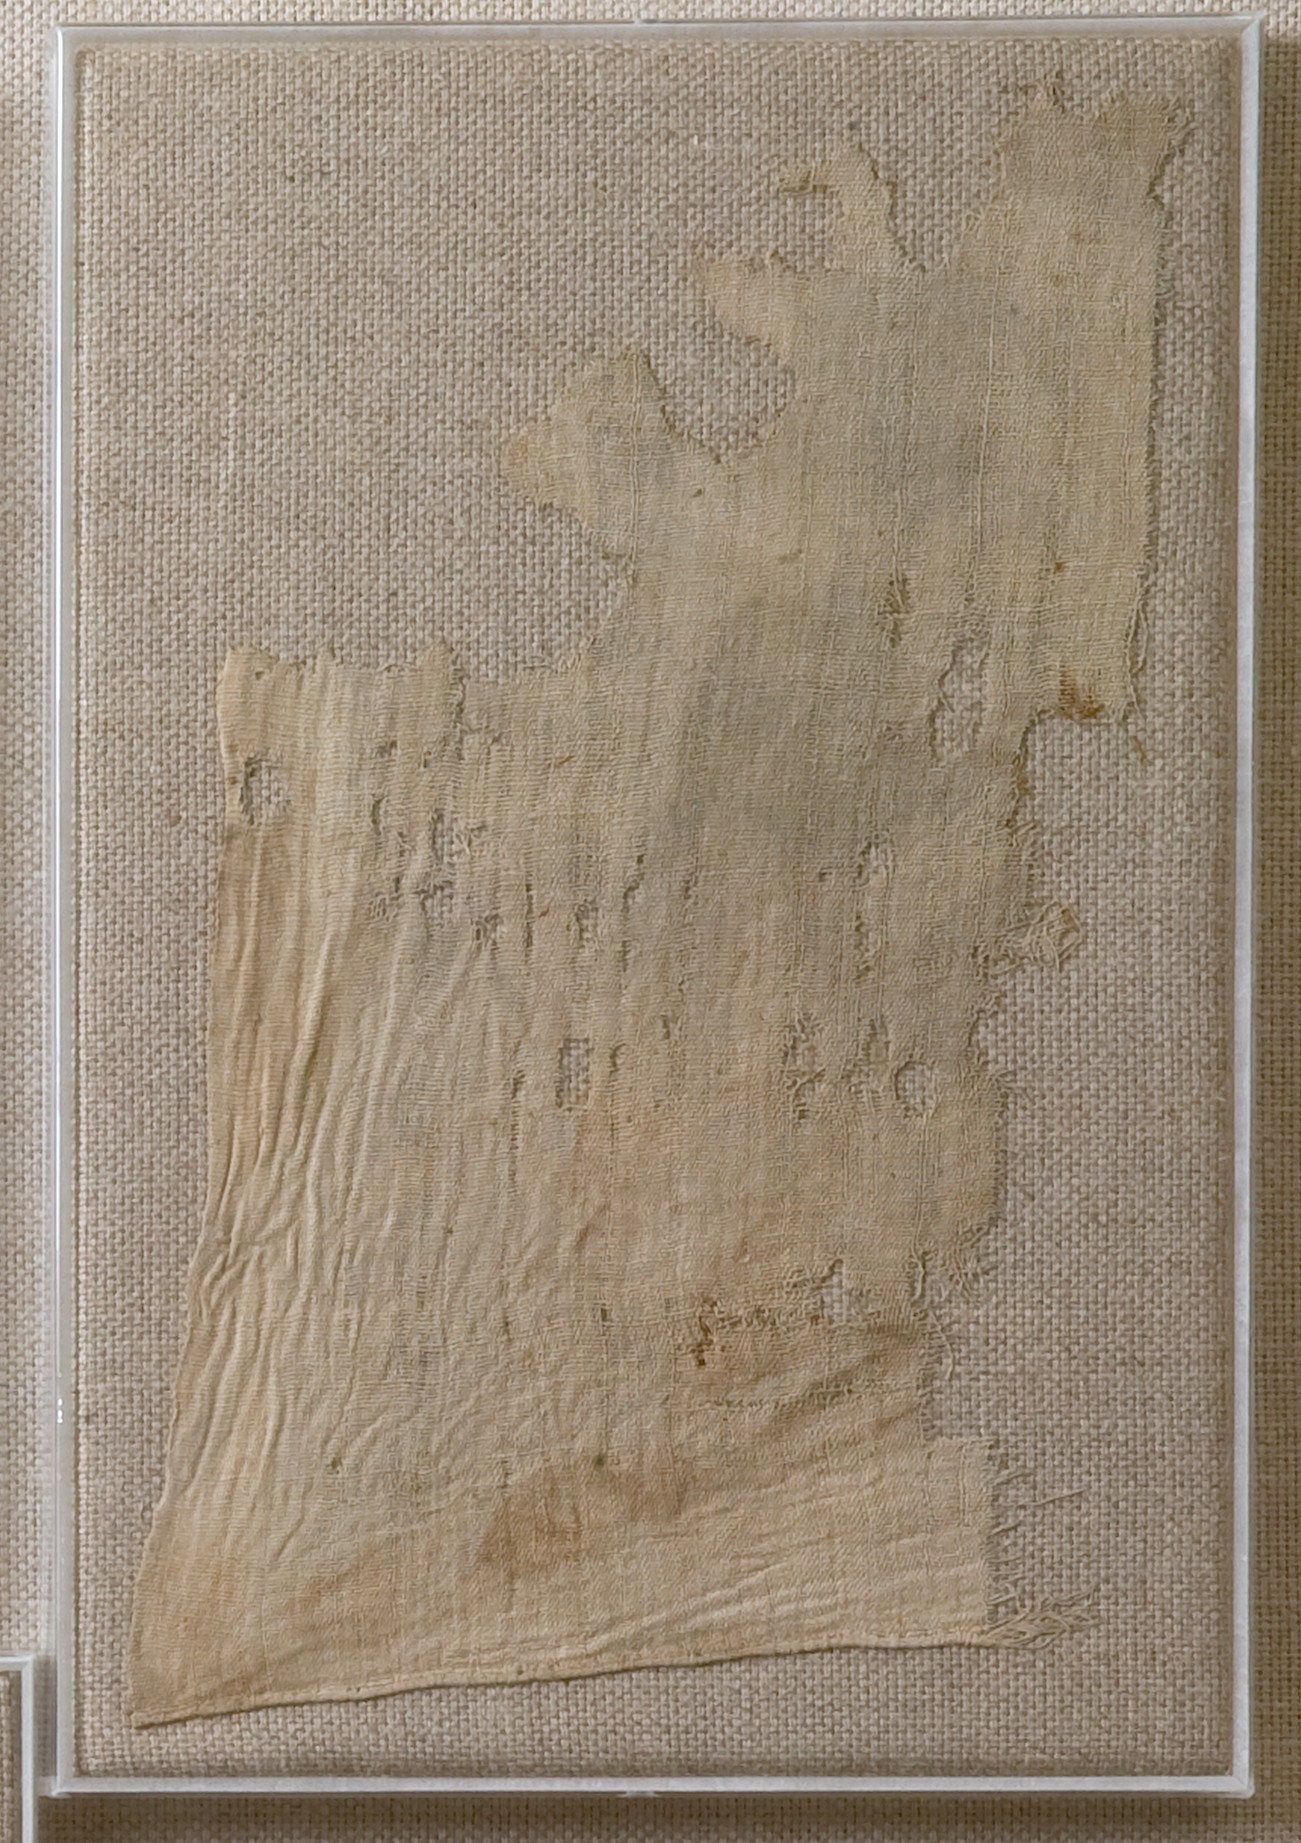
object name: linen fragment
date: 1635-1458 BCE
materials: linen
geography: egypt